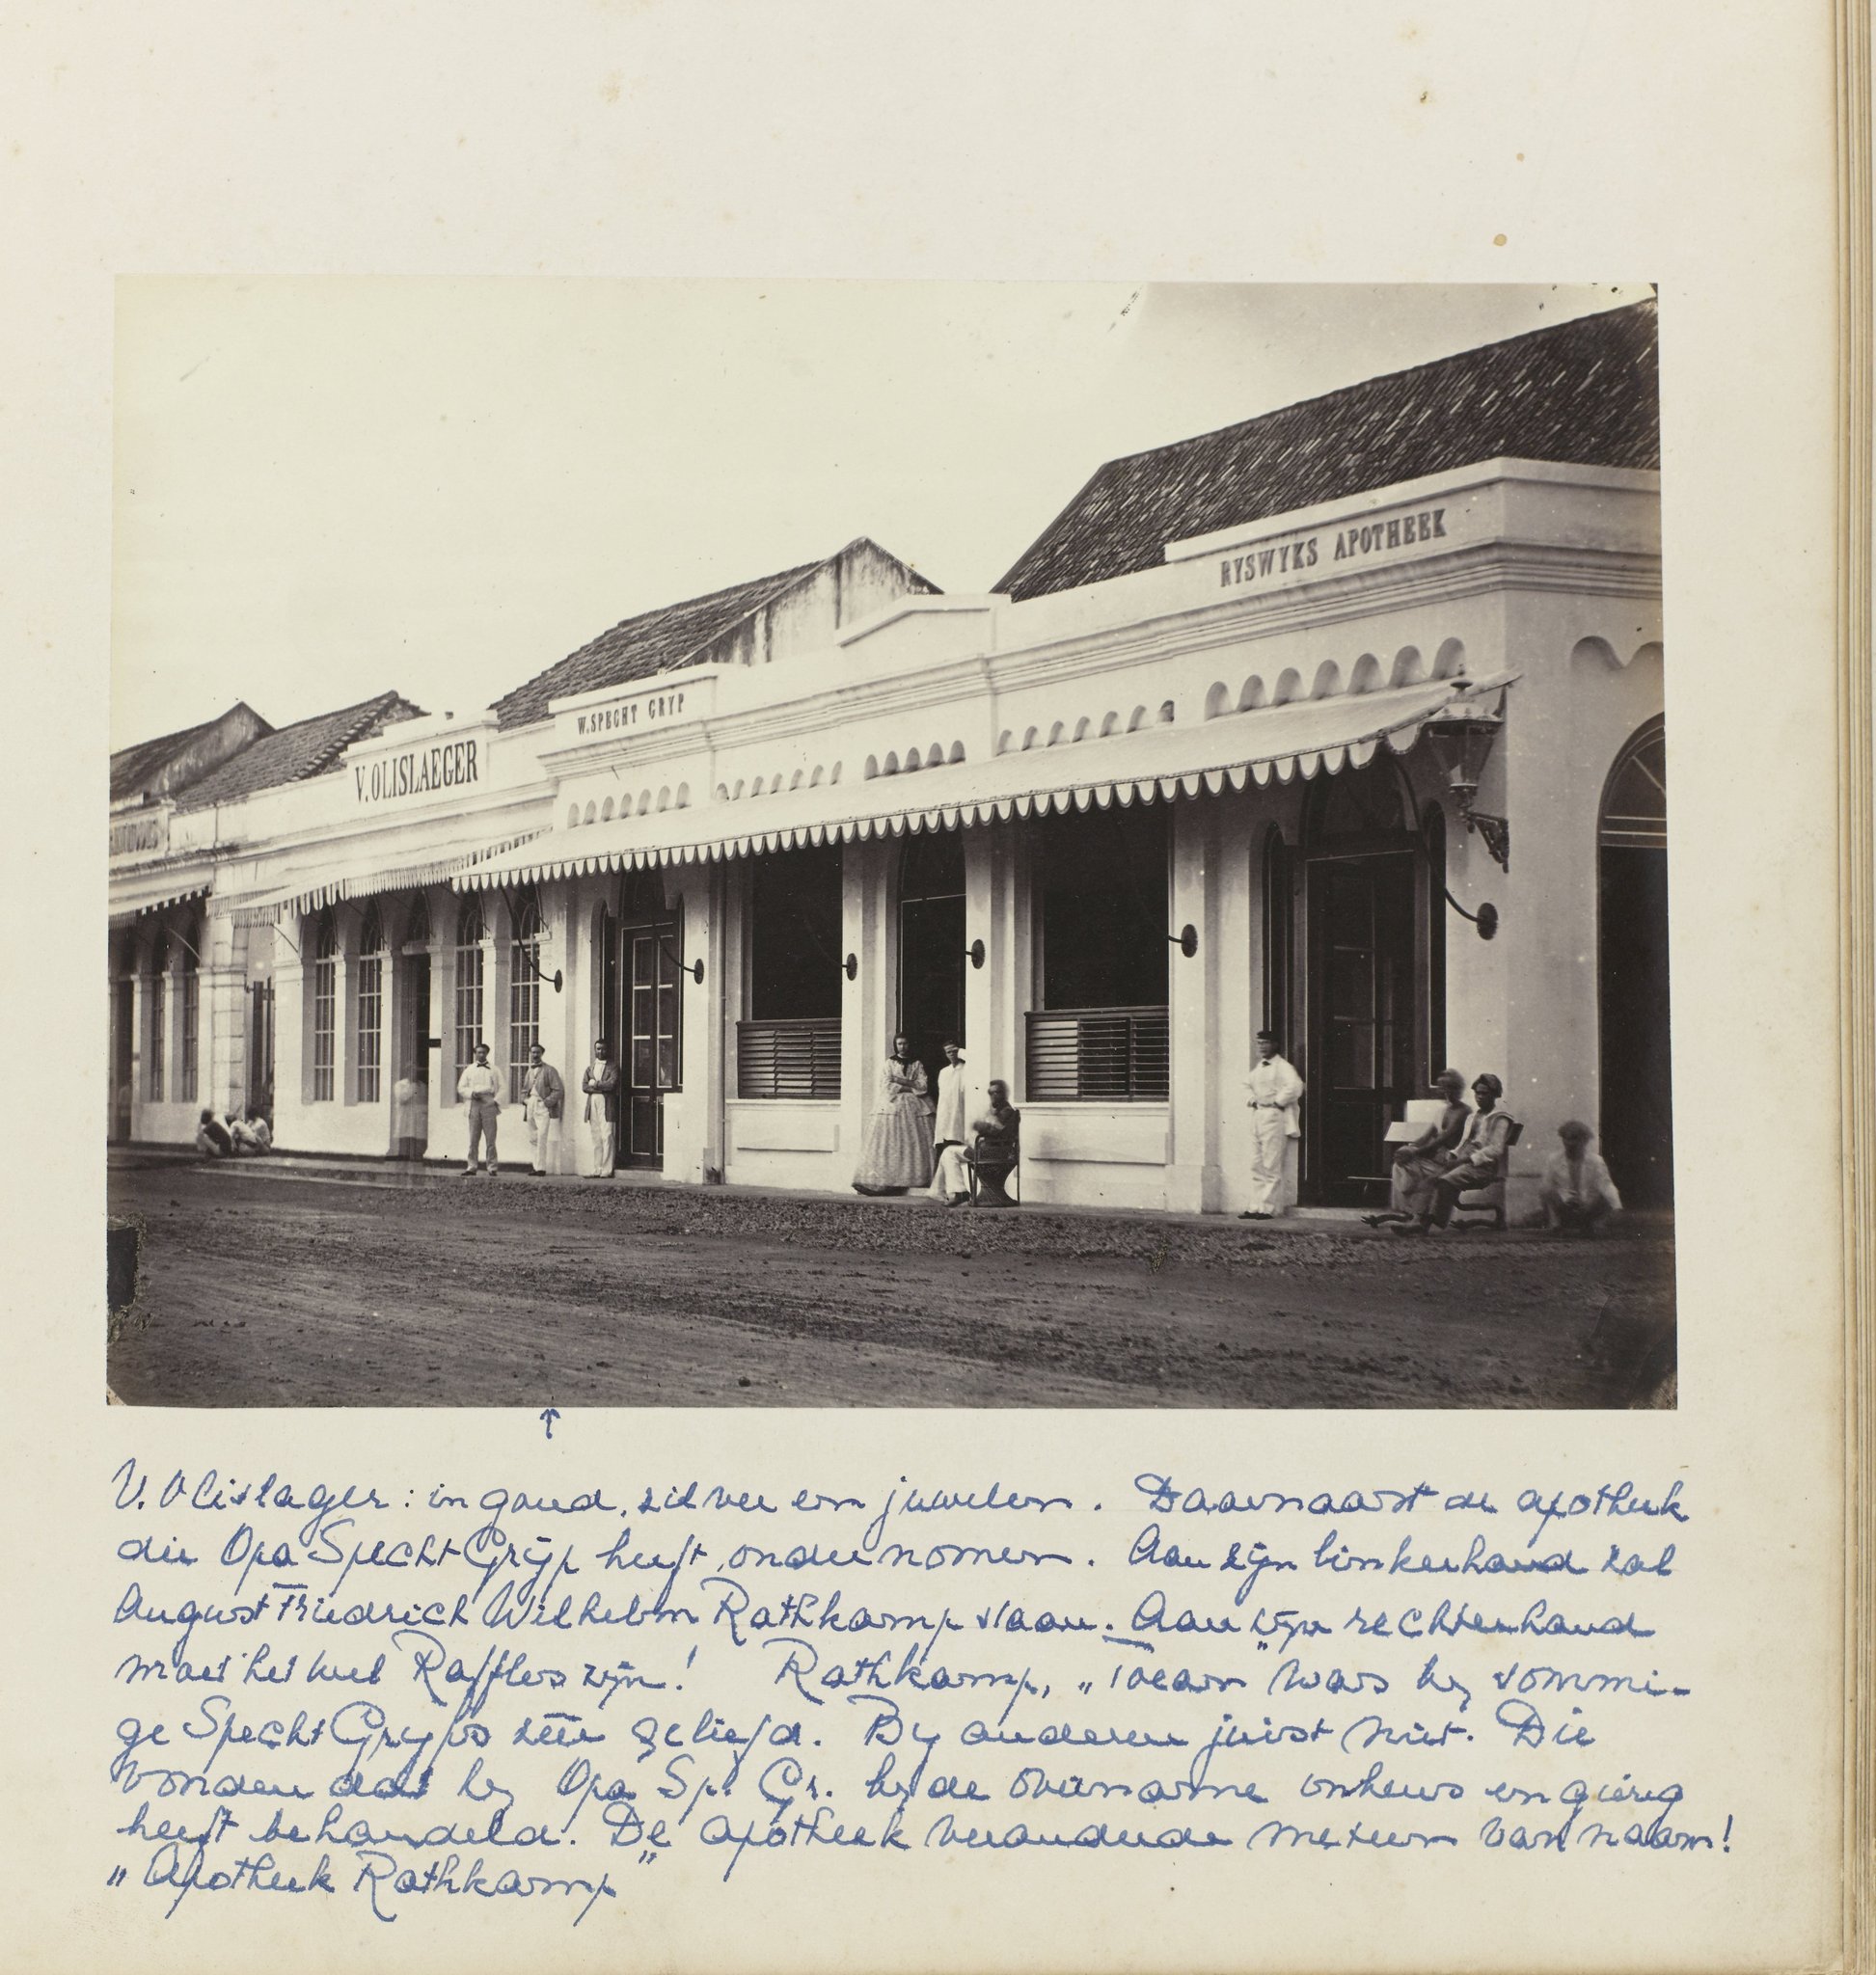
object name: photograph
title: Apotheek Specht Grijp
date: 1863-1866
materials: photographic support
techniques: albumen print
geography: batavia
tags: pharmacist, druggist, apothecary; pharmacy, drugstore, dispensing chemist, batavia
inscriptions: inscription: ‘V. Olieslager ... Daarnaast de apotheek die Opa Specht Grijp heeft ondernomen ... "Apotheek Rathkamp".’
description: De apotheek van Specht Grijp in de Rijswijkstraat in Batavia, links de juwelier V. Olislaeger. Onderdeel van het rode fotoalbum met foto's van Java, uit het bezit van apotheker Specht Grijp, die in 1865 vanuit Batavia naar Nederland terugkeerde.